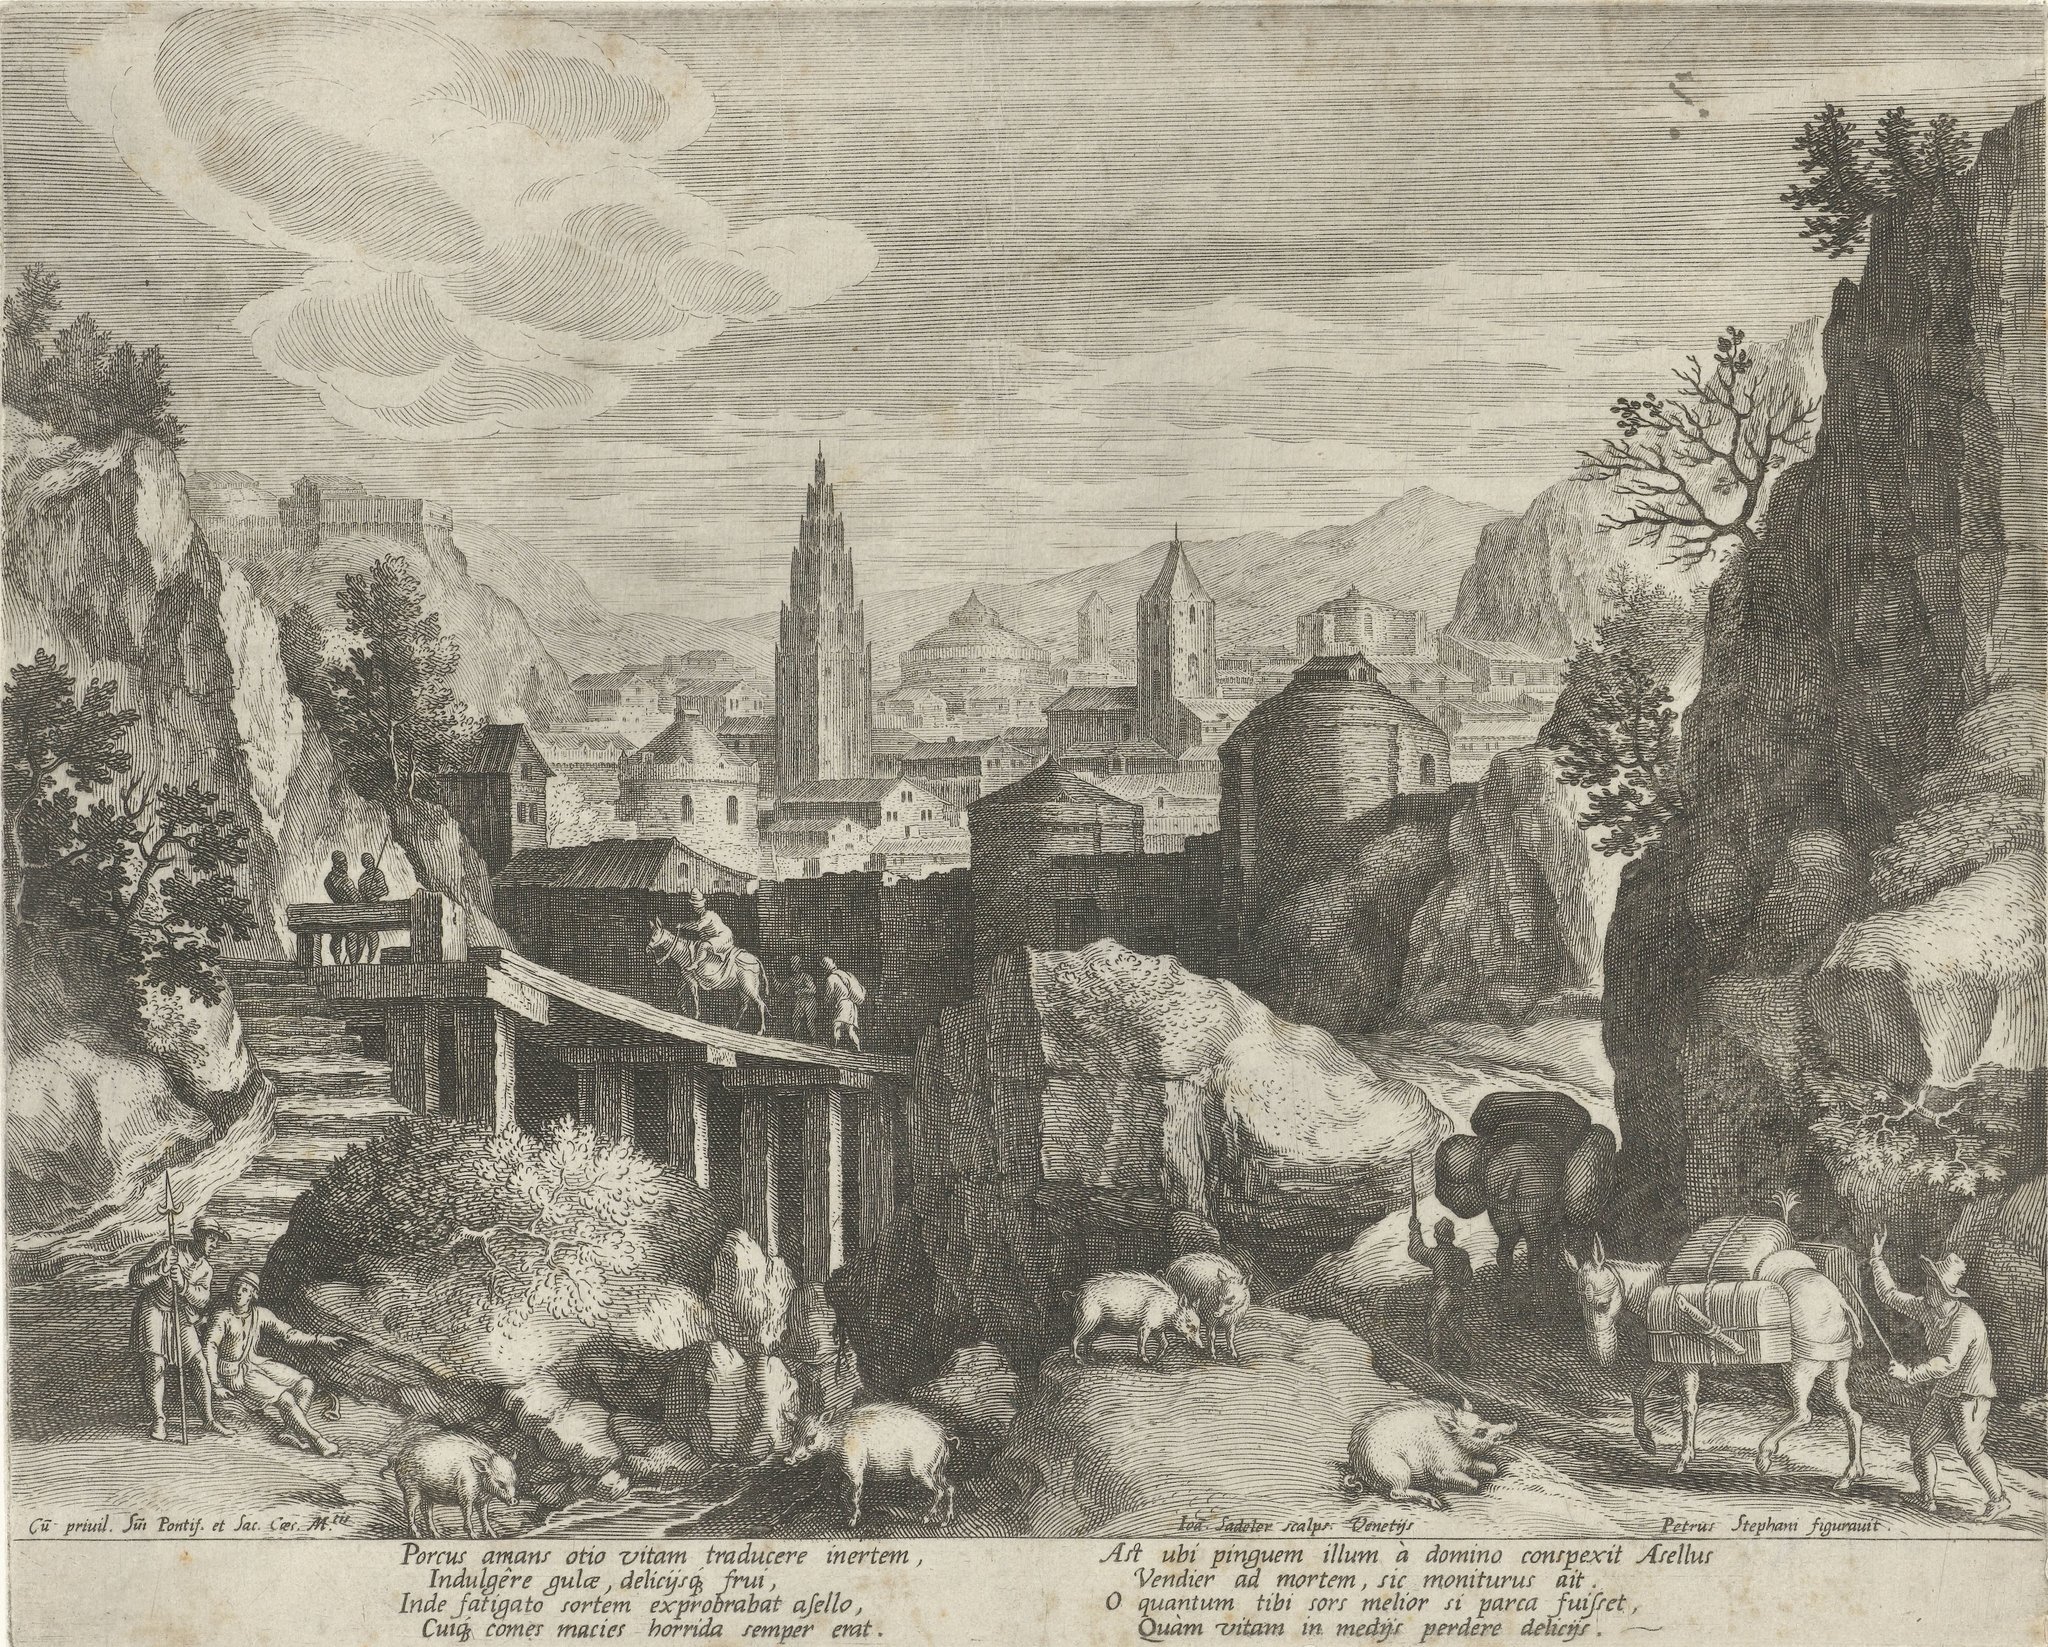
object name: print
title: Rotsachtig landschap met de fabel van de ezel en het wilde zwijn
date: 1595-1600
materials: paper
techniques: engraving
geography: venice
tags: idleness; 'otio' (ripa), pig, ass, donkey, fables, rocks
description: Rotsachtig landschap met een stad op de achtergrond. Links een trap in de heuvels en een houten brug. Op de voorgrond vijf zwijnen. Rechts komen twee beladen ezels de berg op. Een van de ezels confronteert een zwijn met zijn luiheid. Dit is de verbeelding van een fabel van de ezel en het wilde zwijn. De prent heeft een Latijns onderschrift over de fabel.